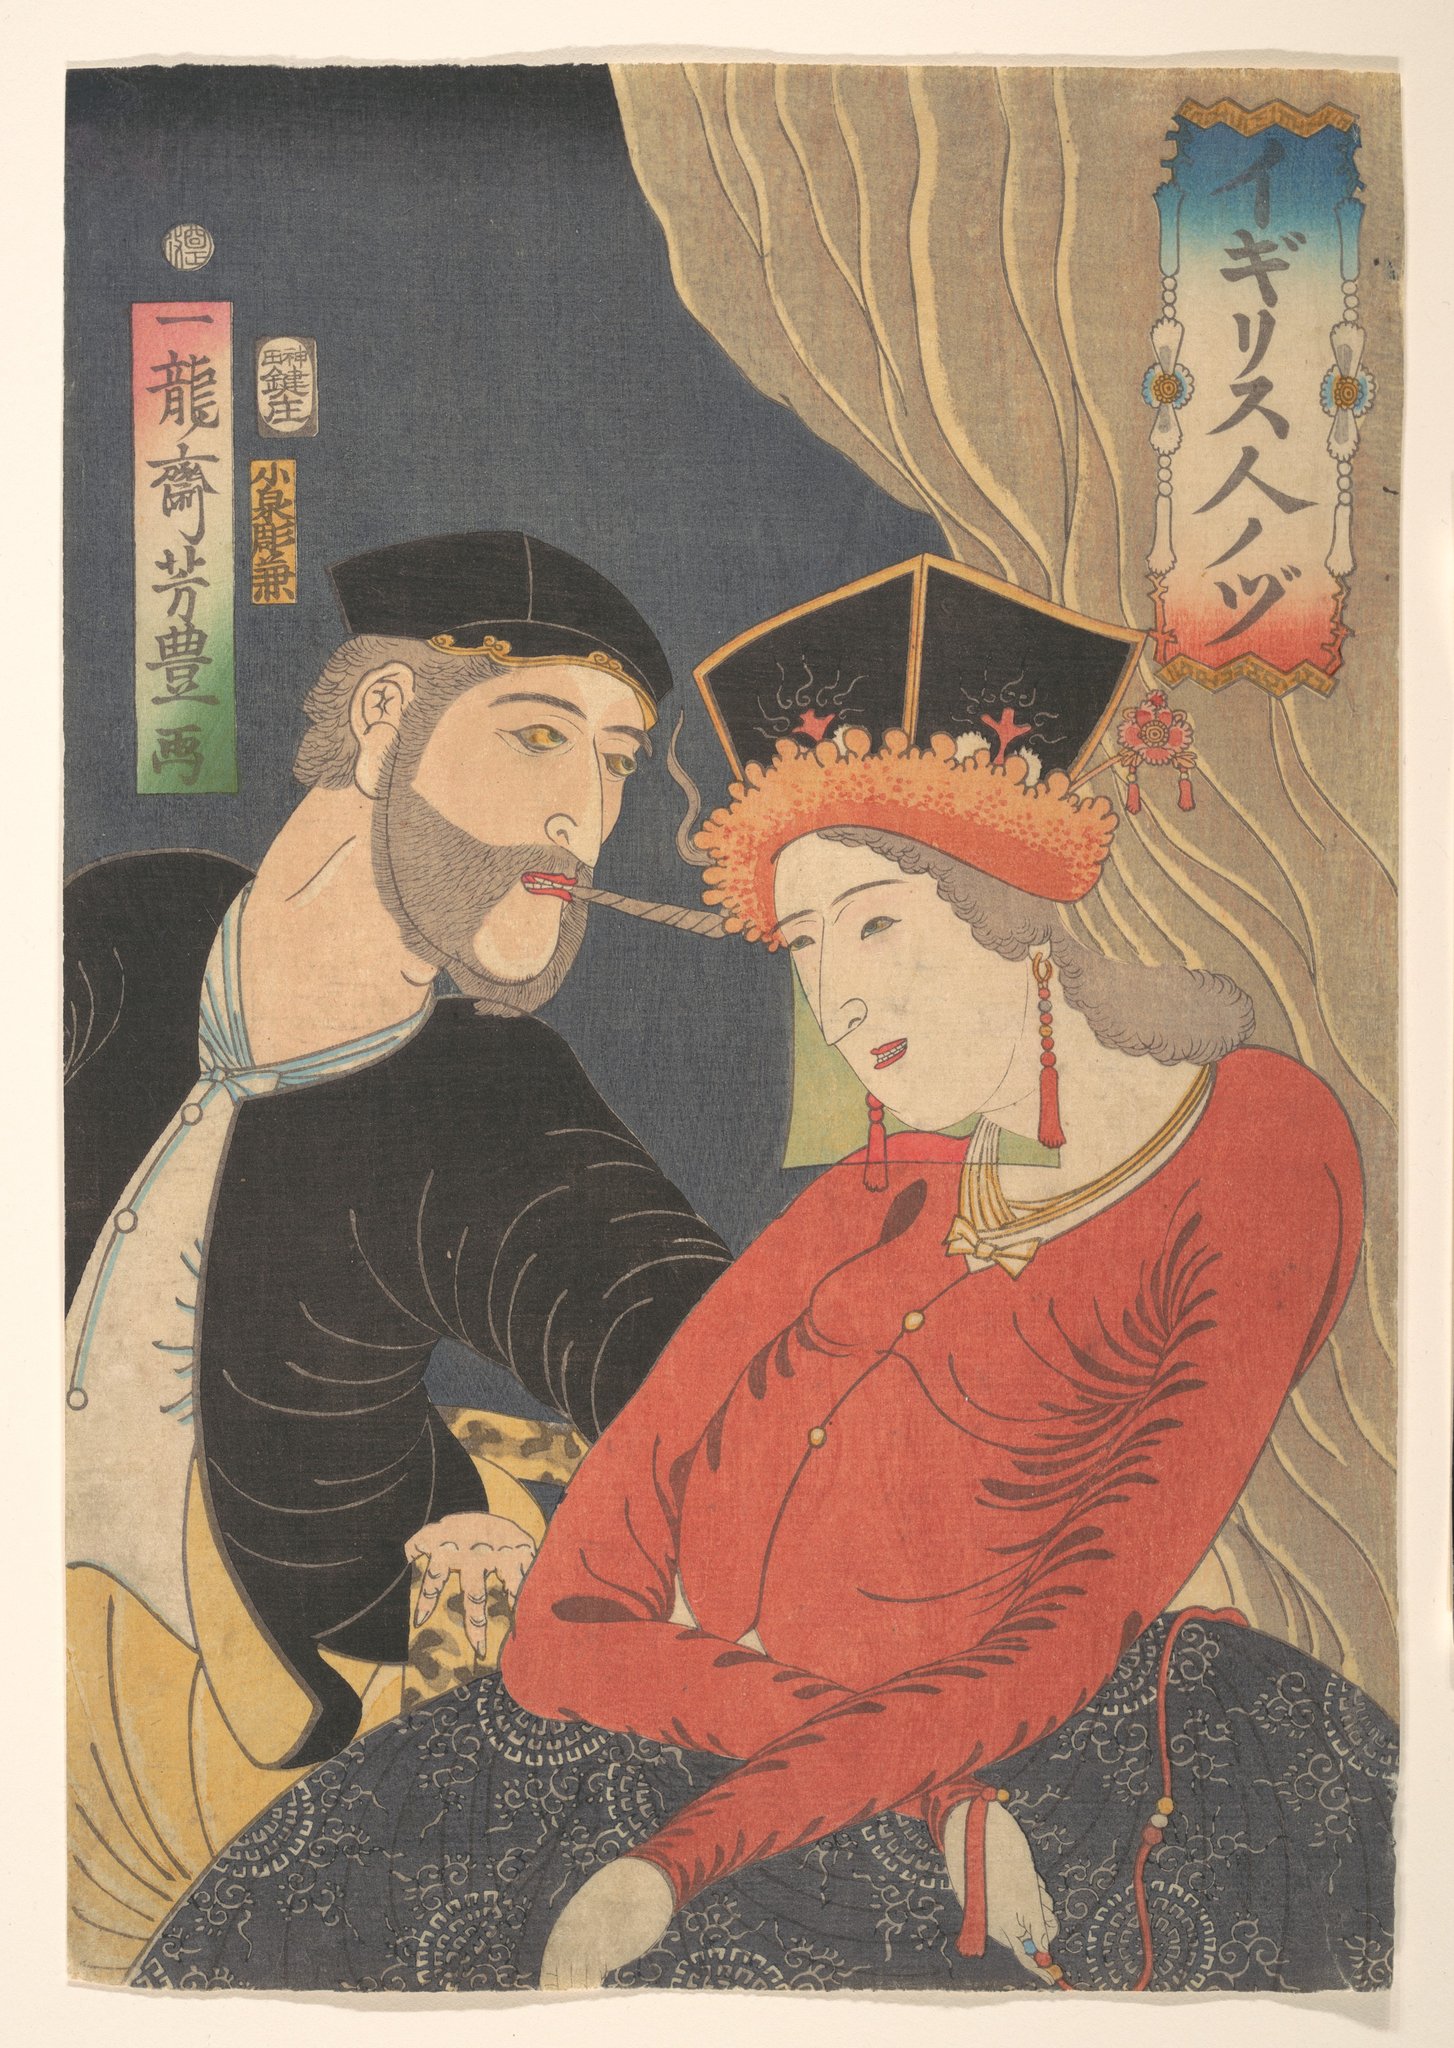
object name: print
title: Illustration of English People (Igirisujin no zu)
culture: japanese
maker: ichiryūsai yoshitoyo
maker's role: artist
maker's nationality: japanese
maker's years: 1830-1866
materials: ink, paper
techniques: woodblock print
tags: men,women,smoking